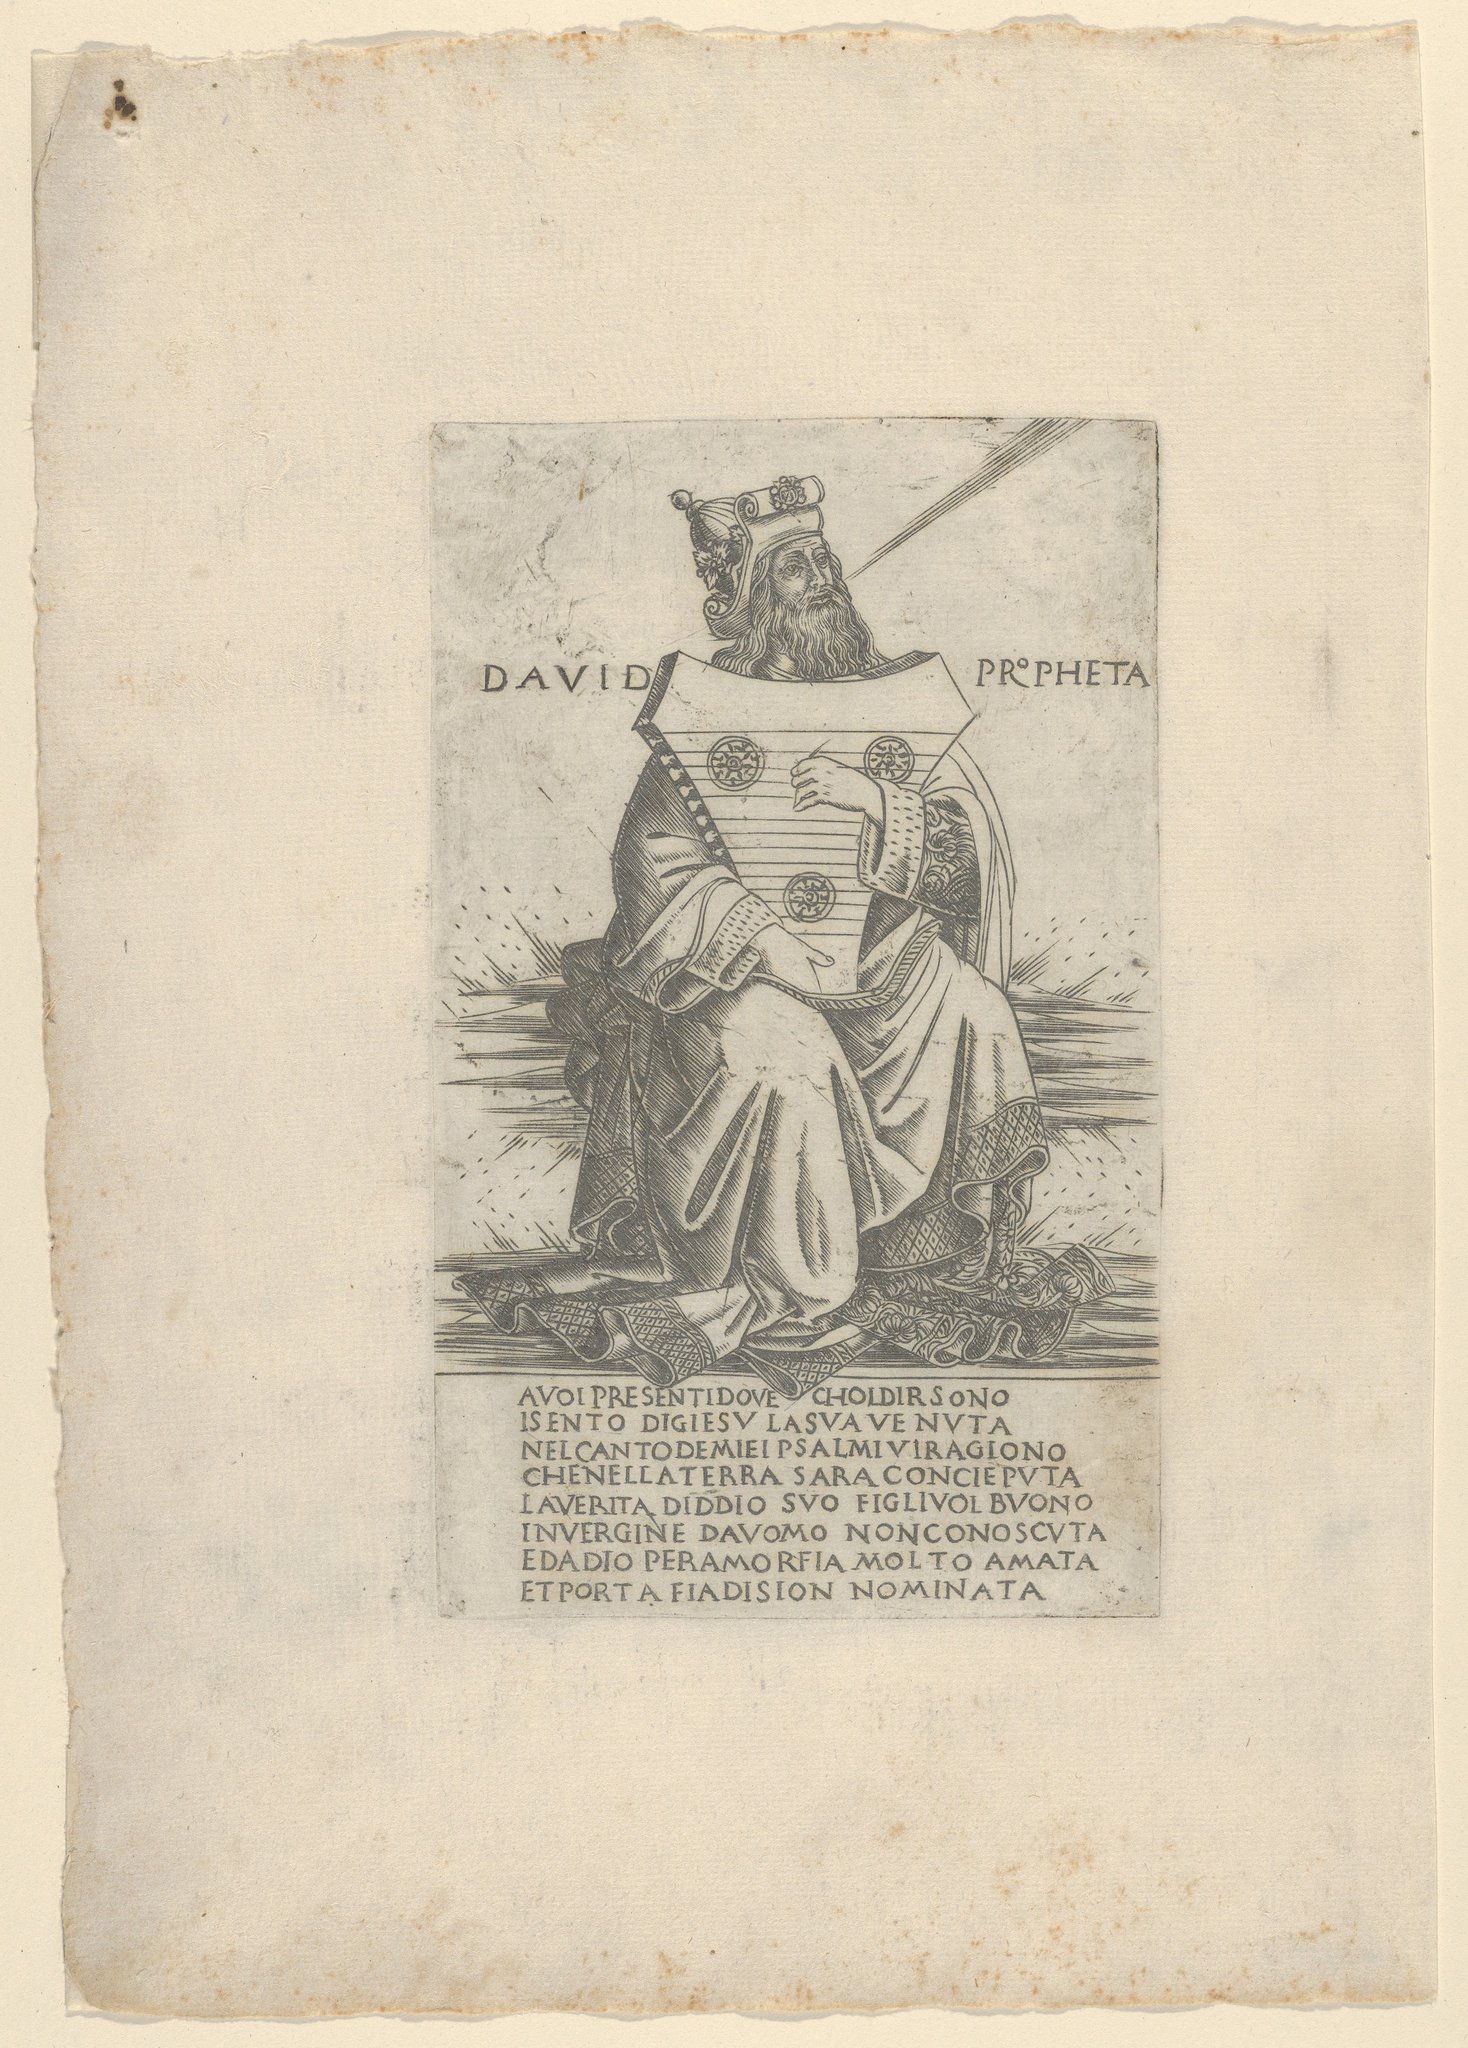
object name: print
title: The Prophet David, from Prophets and Sibyls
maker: francesco rosselli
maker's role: artist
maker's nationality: italian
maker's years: 1448-1527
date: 1480-1490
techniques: engraving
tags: david